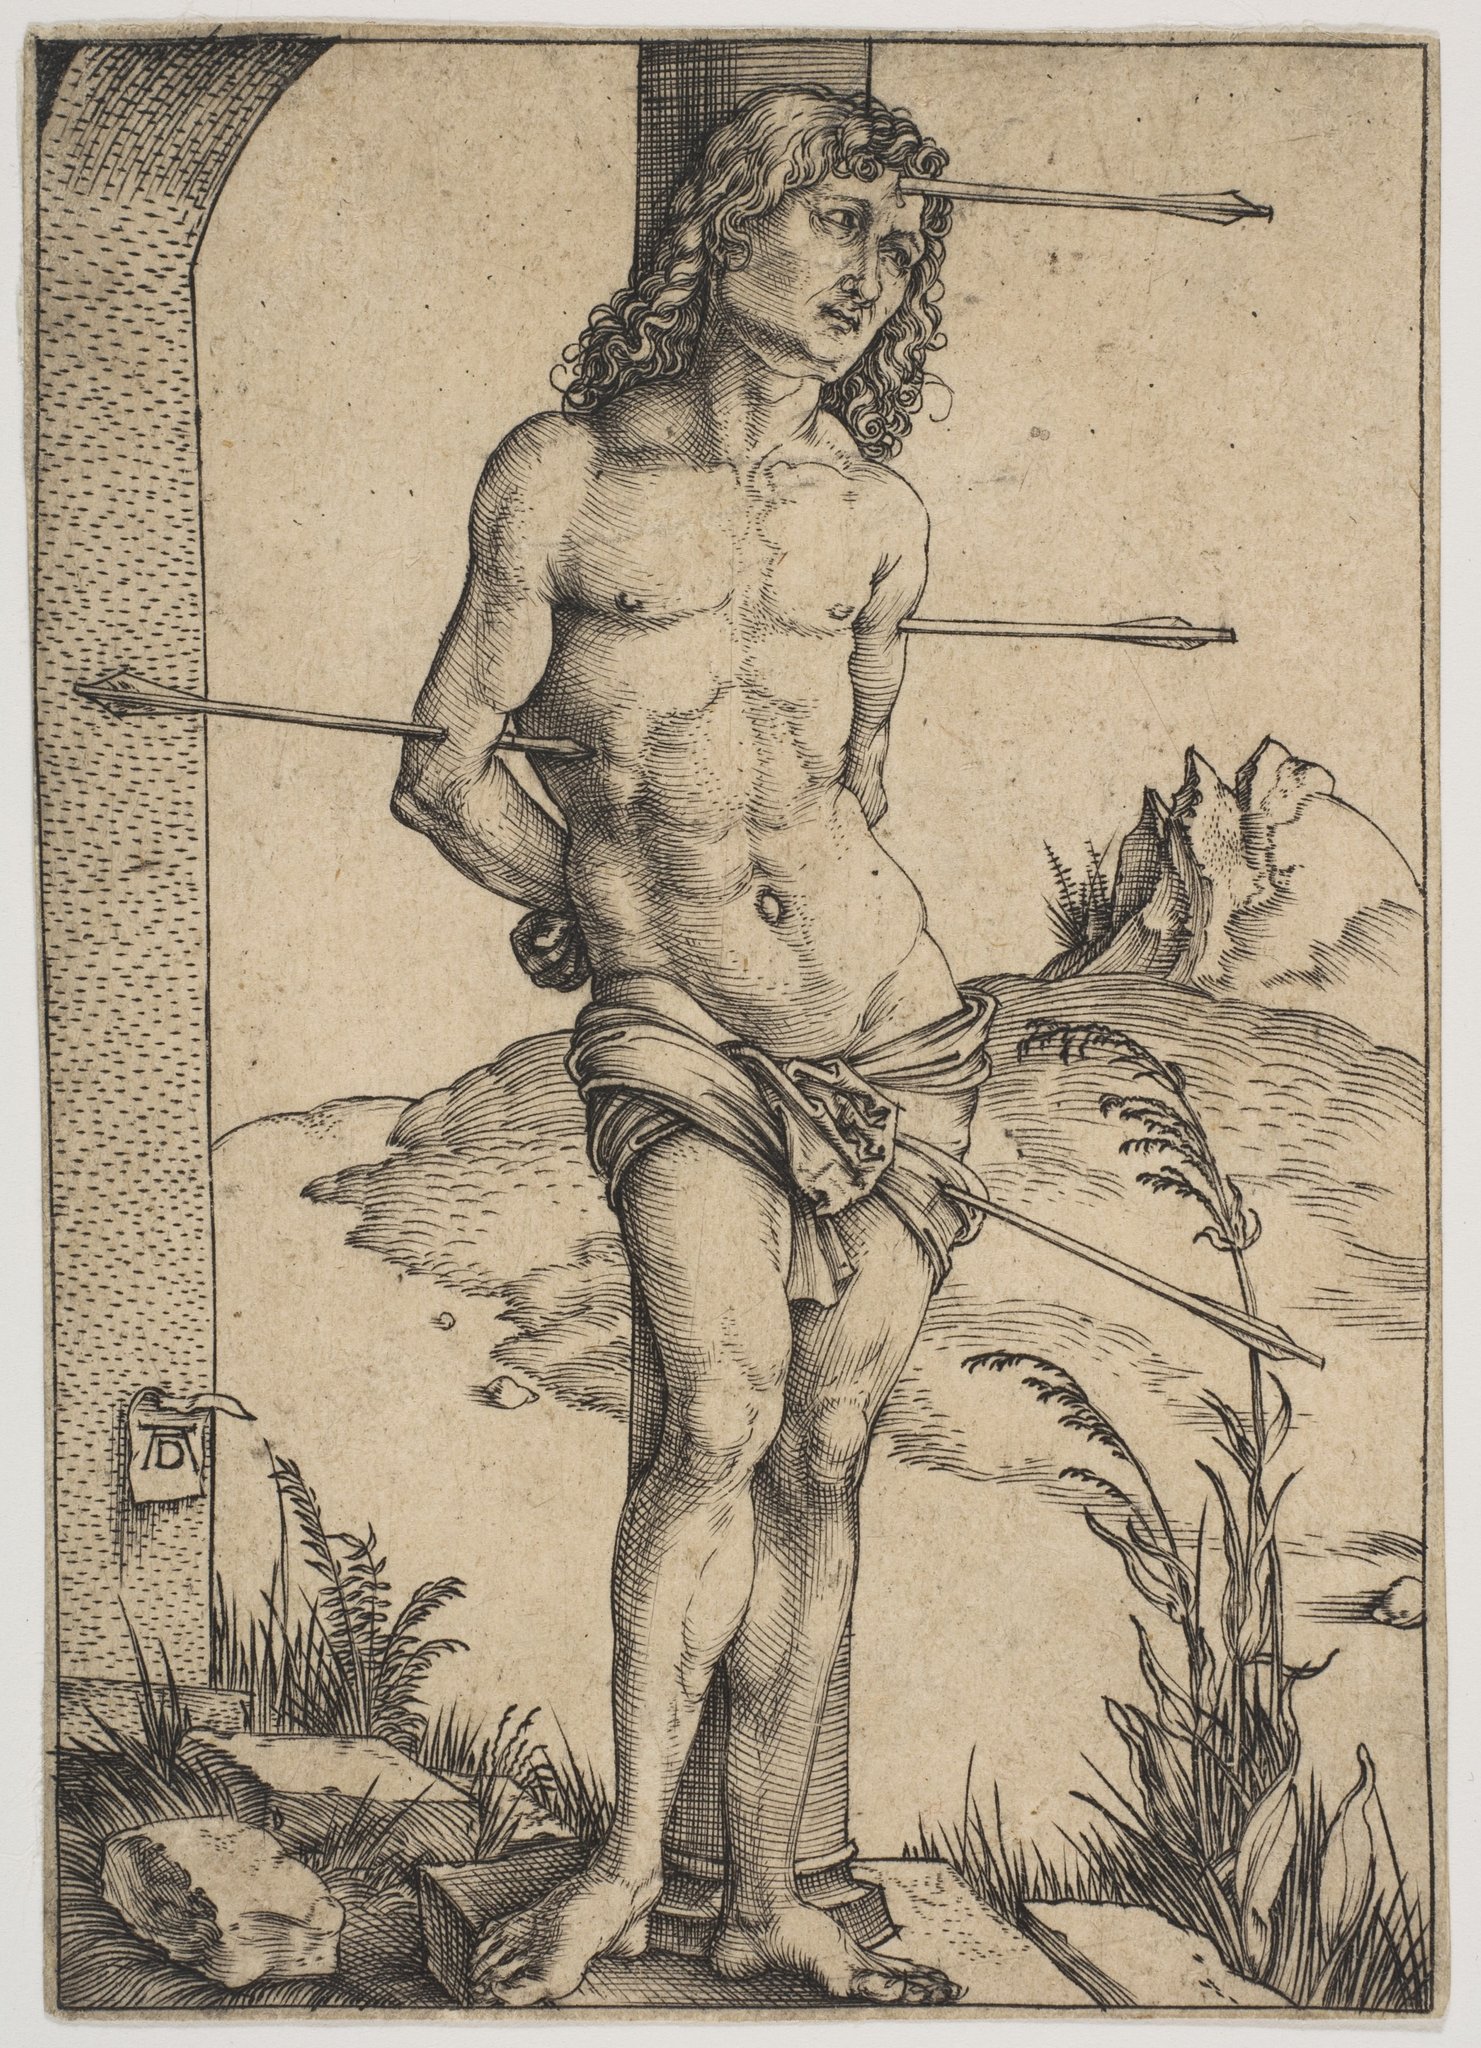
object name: print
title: Saint Sebastian Bound to the Column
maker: albrecht dürer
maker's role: artist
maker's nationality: german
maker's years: 1471-1528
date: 1499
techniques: engraving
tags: men,saints